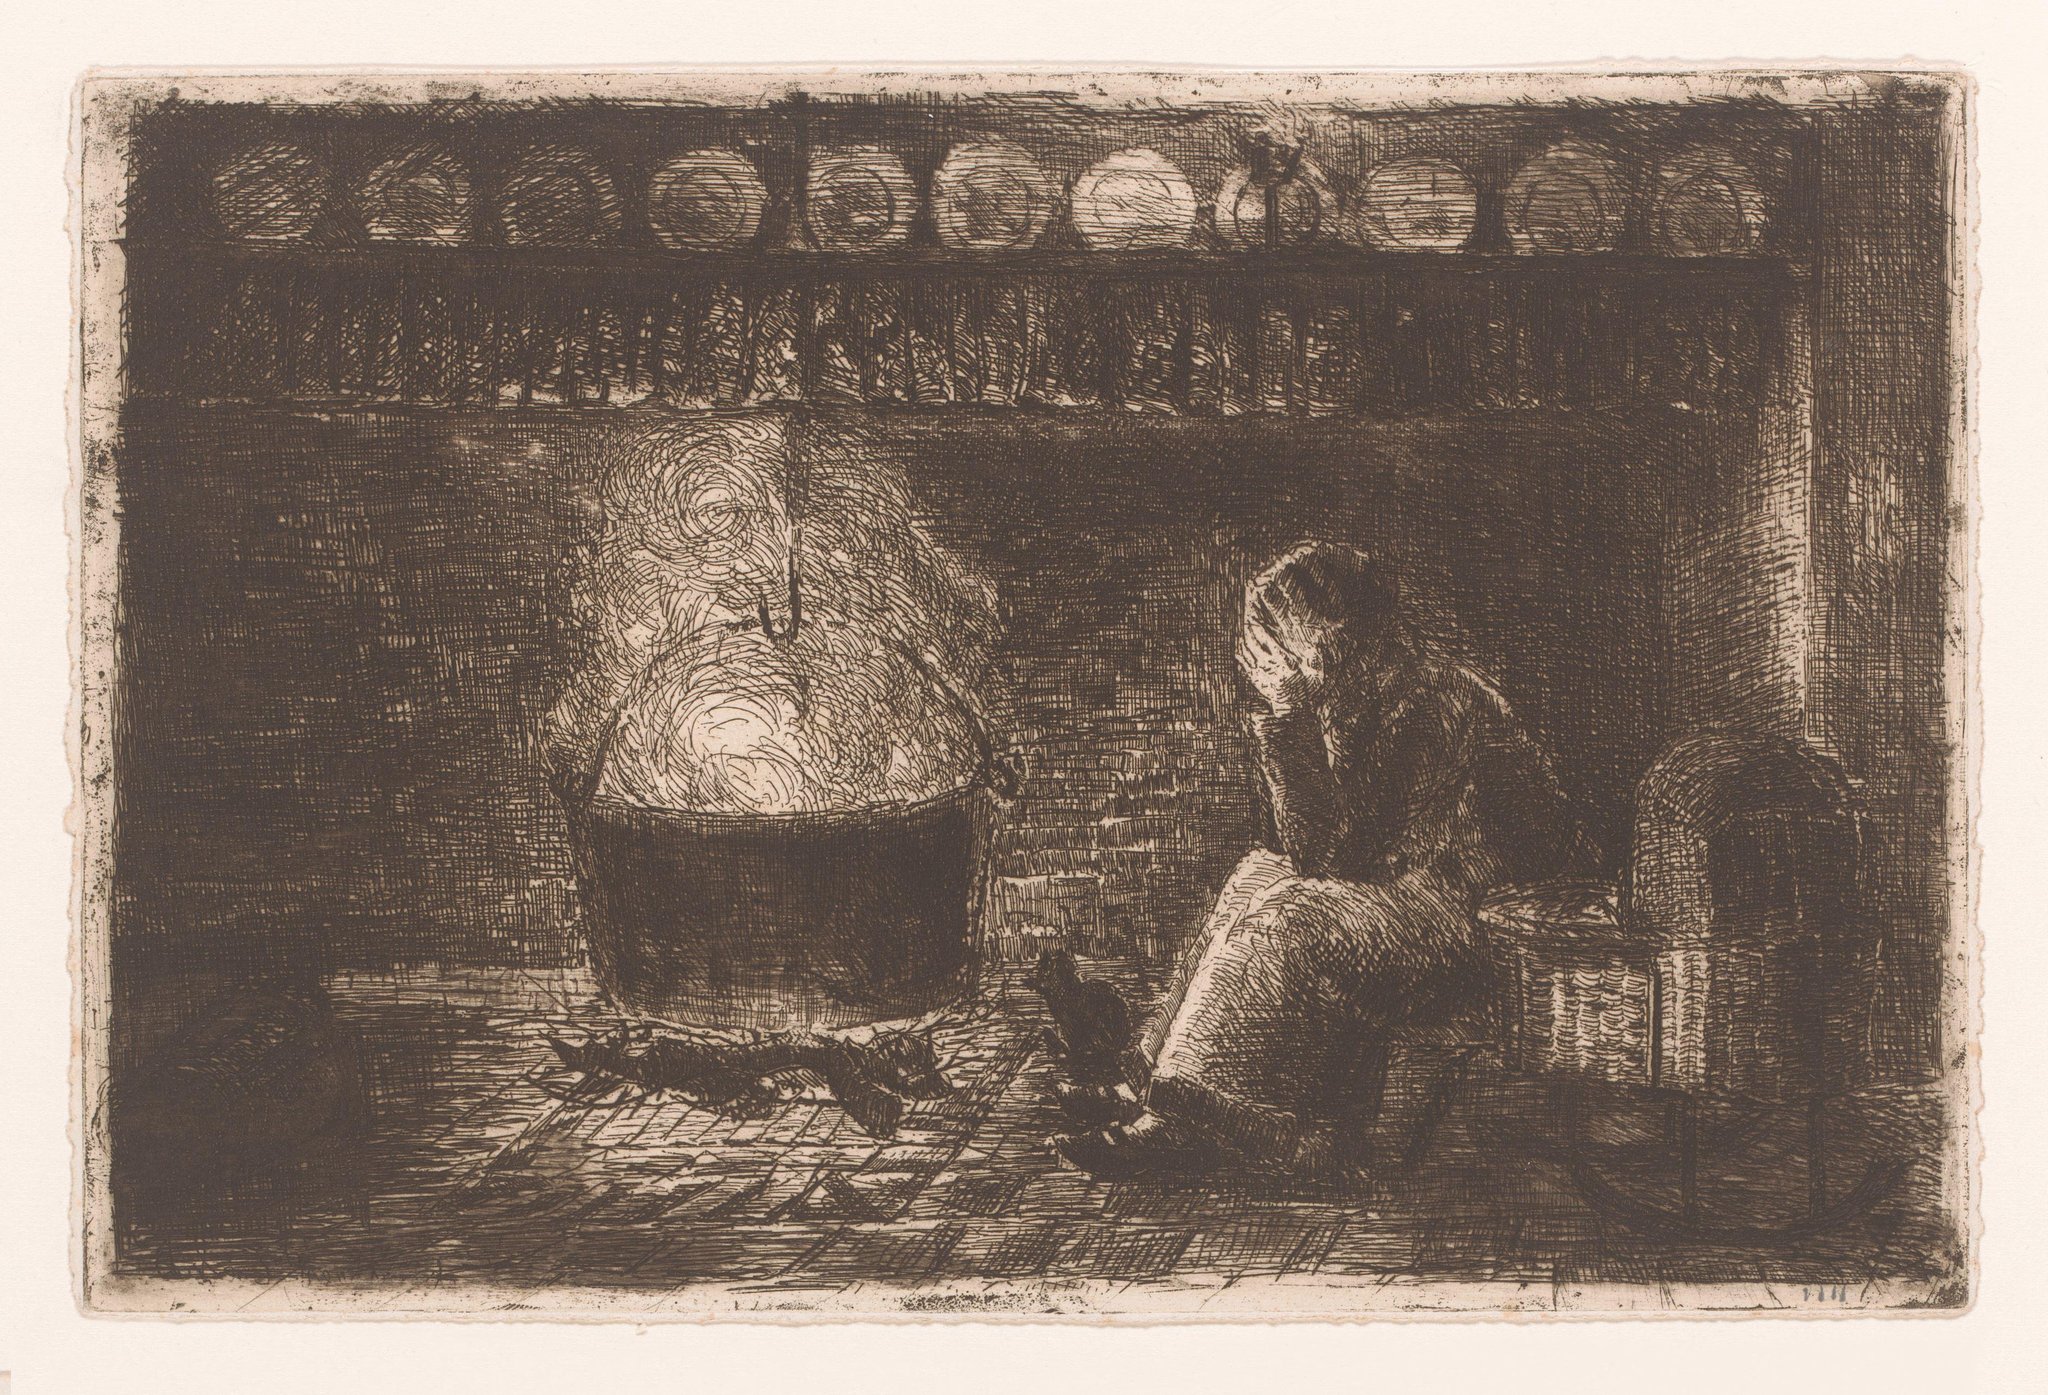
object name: print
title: Vrouw zittend bij de haard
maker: theodoor verstraete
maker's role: painter, print maker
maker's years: 1850-1907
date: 1860-1907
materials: paper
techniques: drypoint, etching, retroussage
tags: adult woman, open hearth, fire-place, head held in the hand(s), with elbows leaning on an elevation or on the knees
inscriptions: collector's mark: Lugt 2228